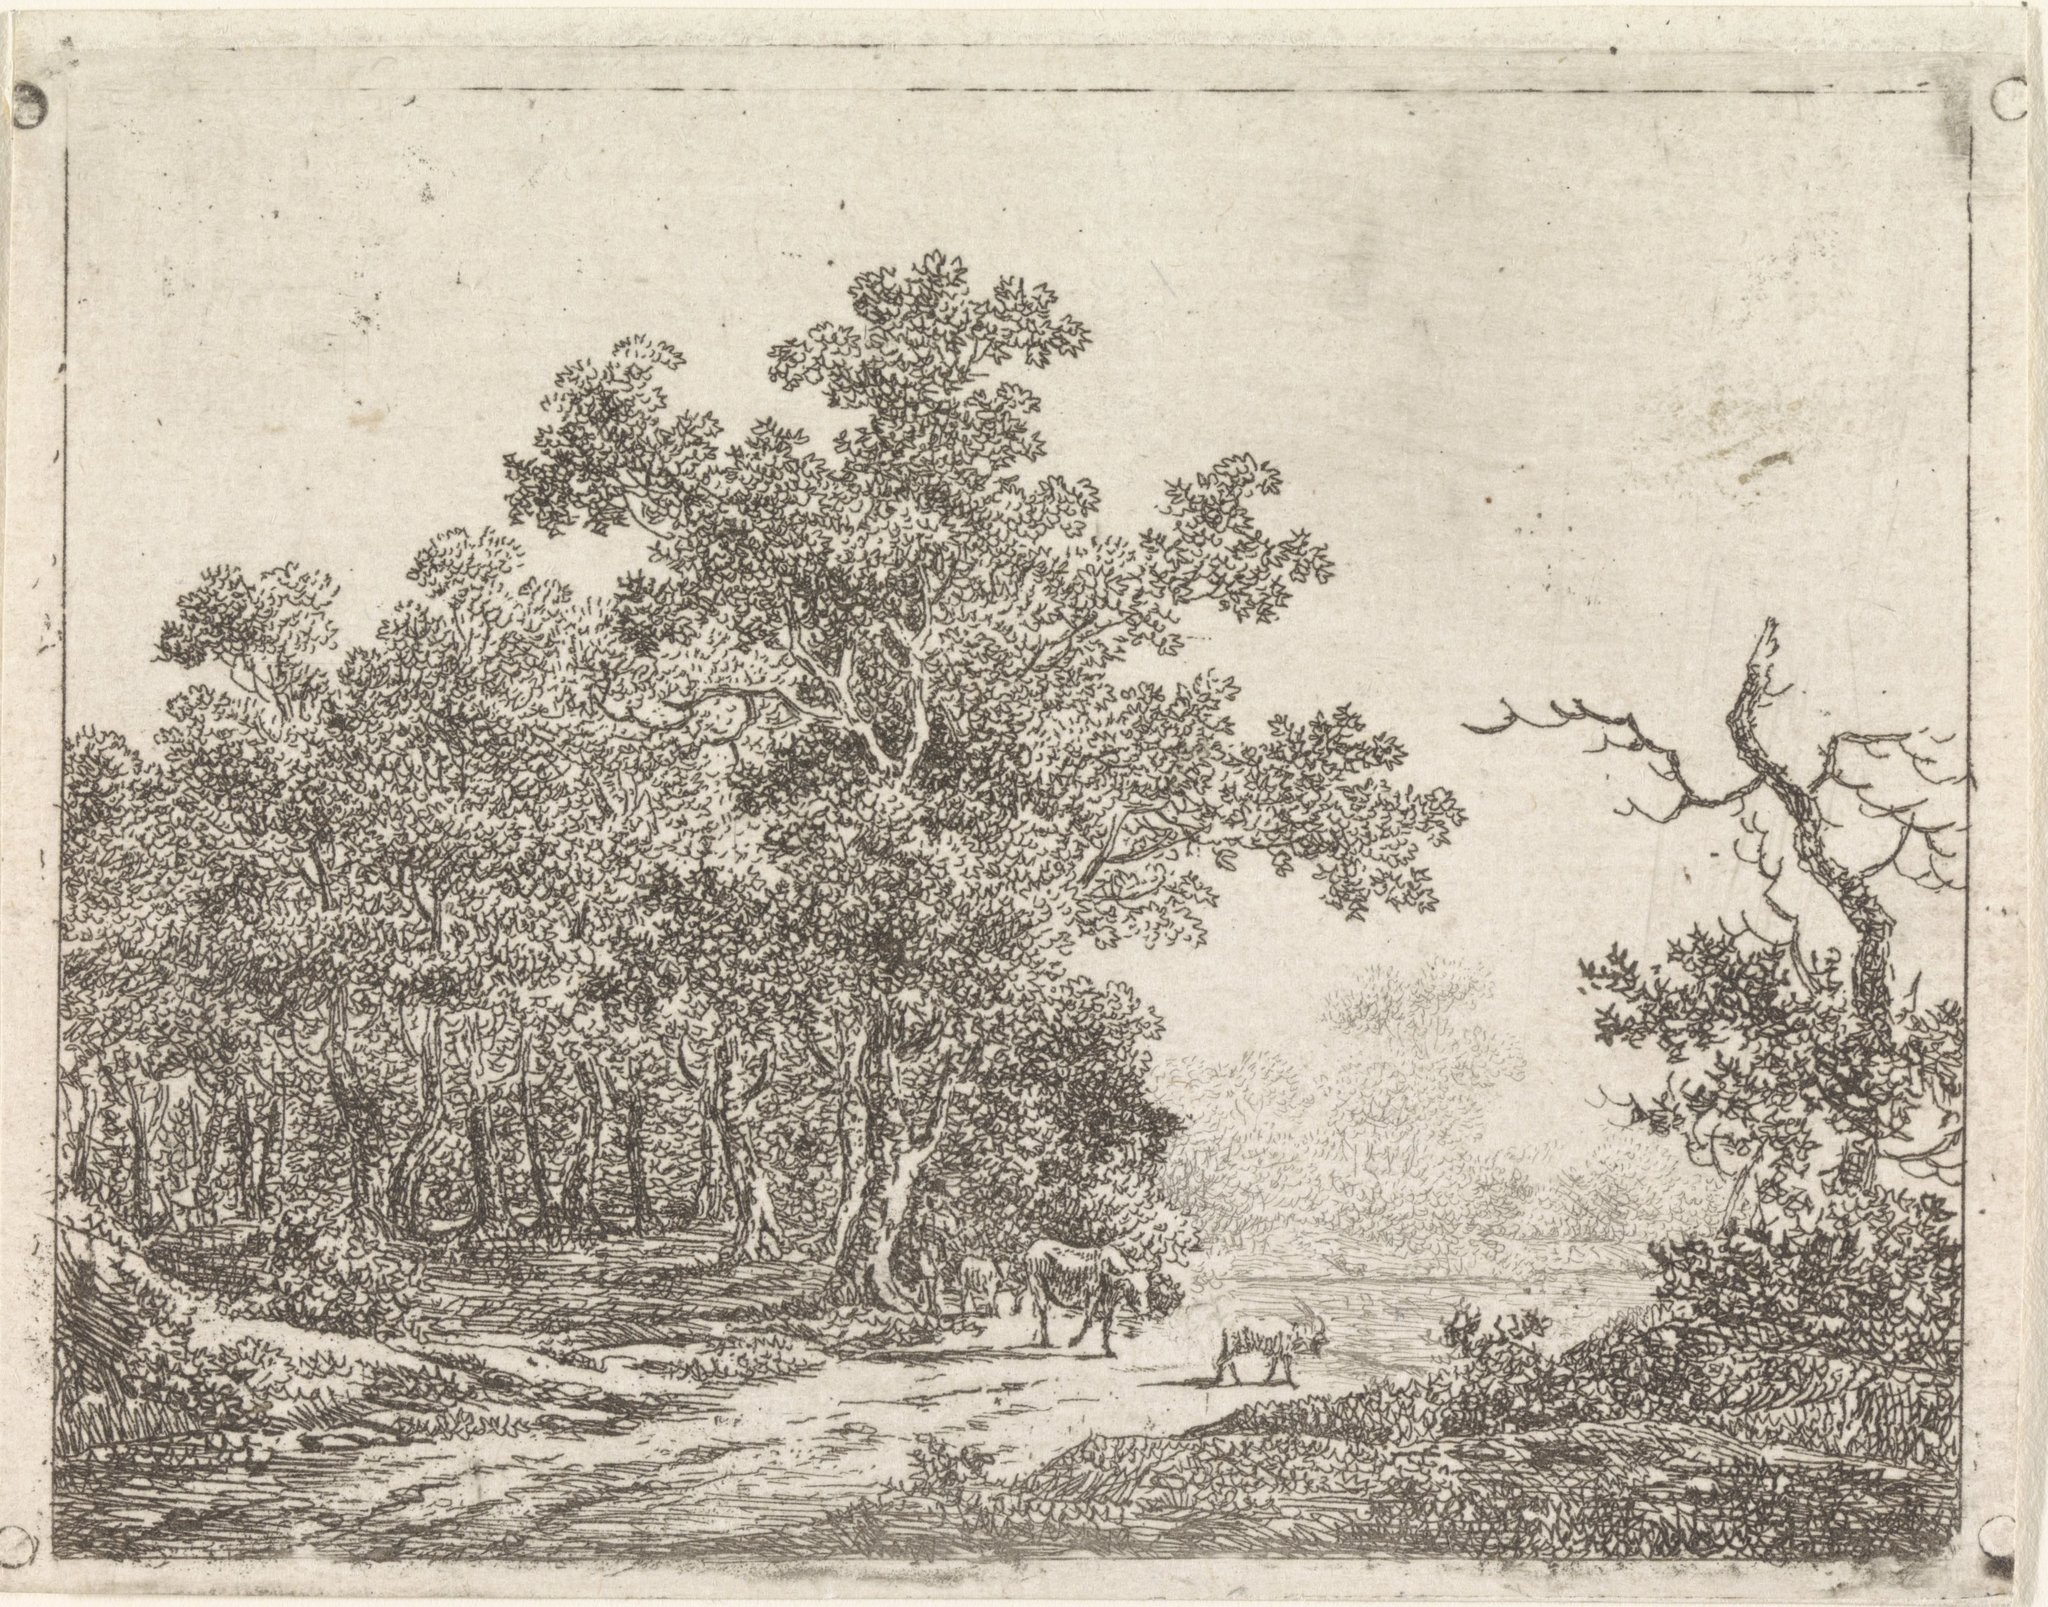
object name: print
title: Landschap met eik en vee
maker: johannes christiaan janson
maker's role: draughtsman, painter, print maker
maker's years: 1763-1823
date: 1778-1823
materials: paper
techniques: etching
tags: cow, sheep, landscapes (+ landscape with figures, staffage)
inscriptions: collector's mark: Lugt 2228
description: Landschap met eik en een herder. De herder drijf zijn koe, schaap en geit over een pad naar het water. Rechts op de voorgrond een kale boom. Vóór de lucht en vóór het tweede schaap.